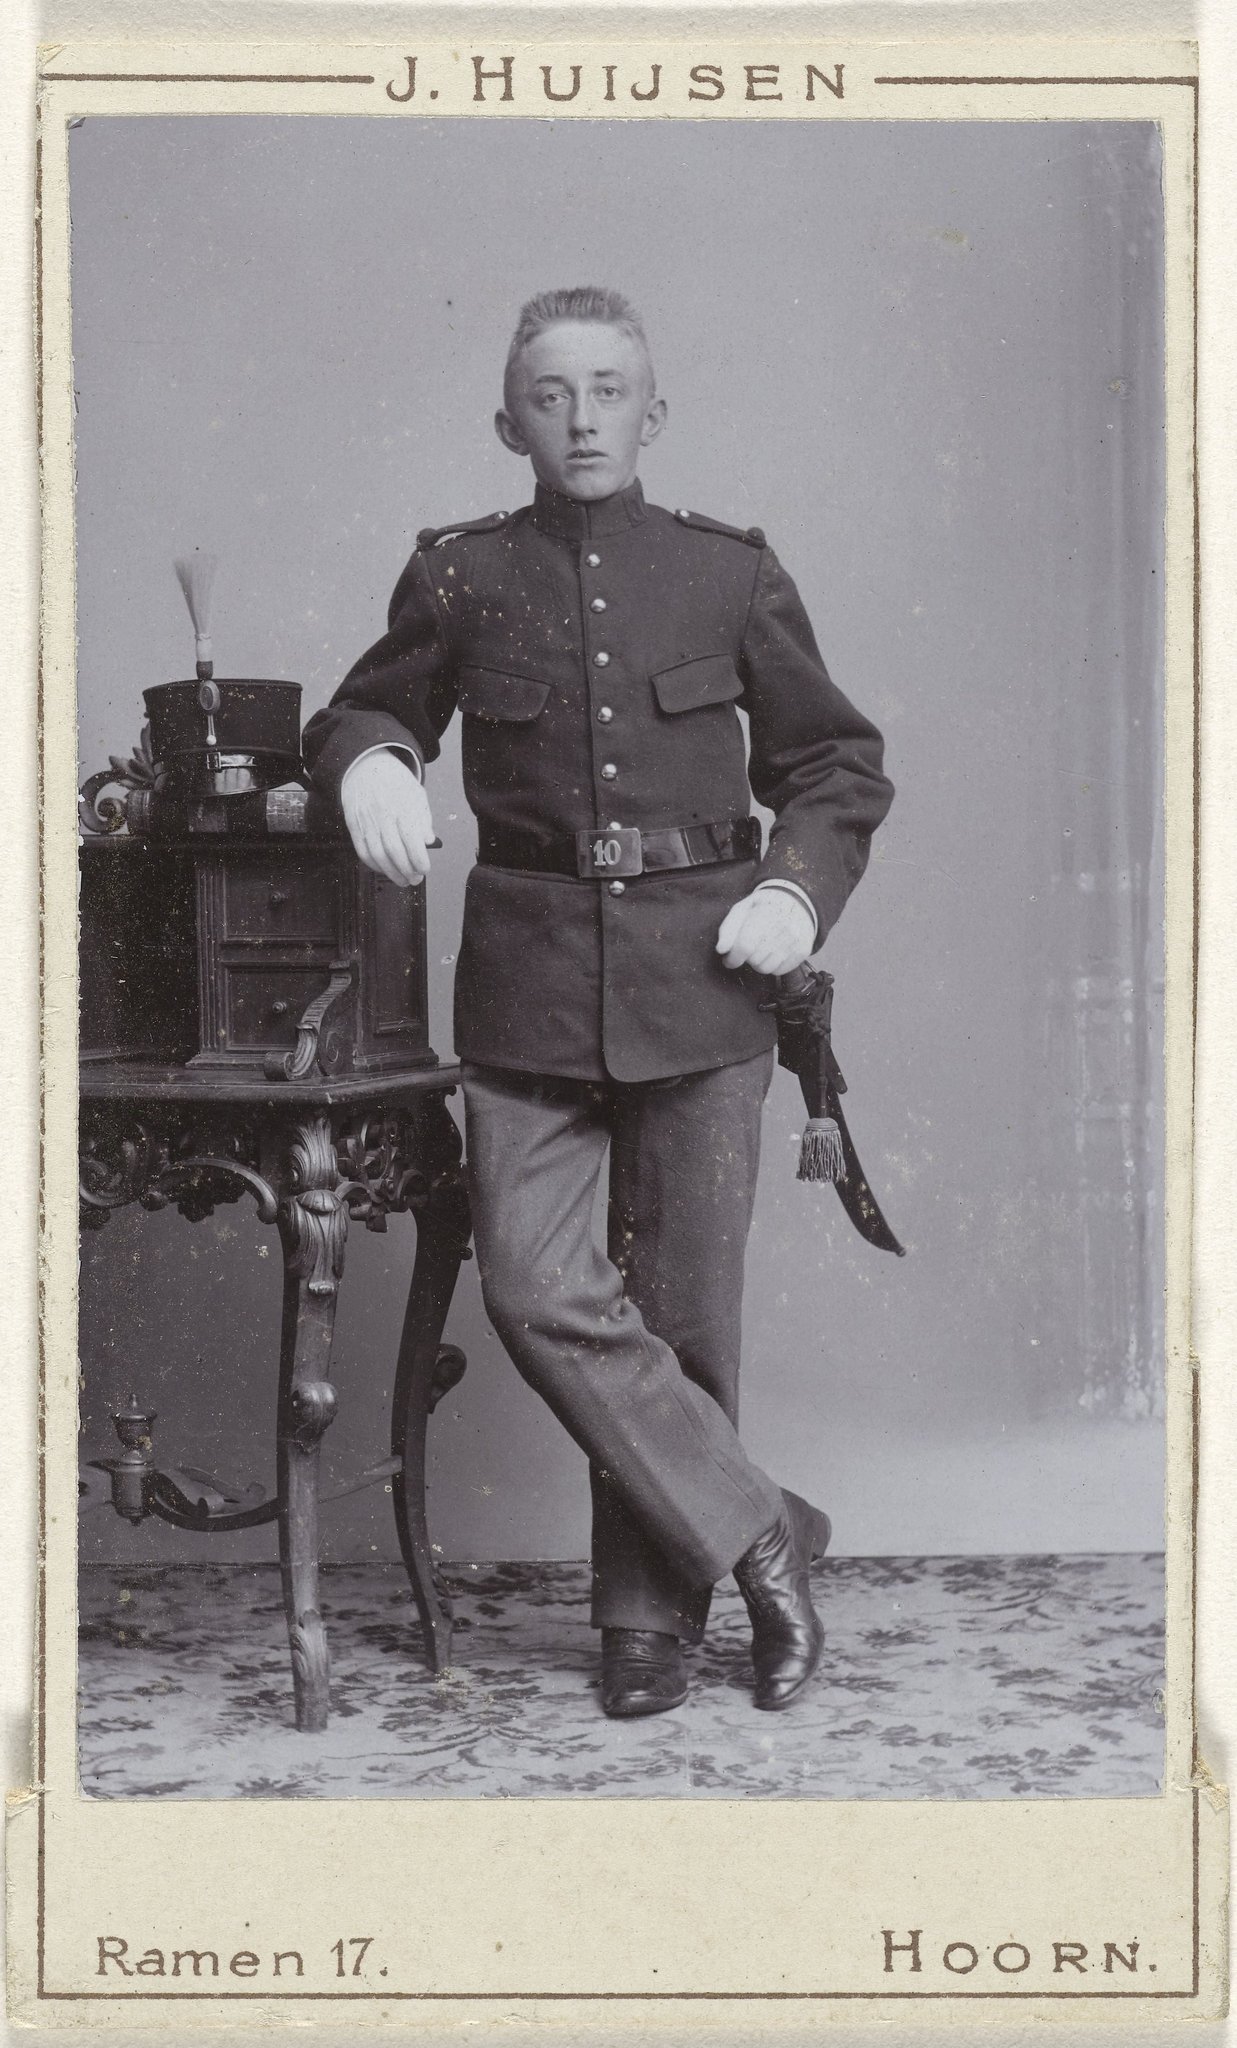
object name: photograph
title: Studioportret van man in uniform bij dressoir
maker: johannes laurens theodorus huijsen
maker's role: fotograaf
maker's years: 1852-1910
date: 1900-1920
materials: photographic support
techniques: albumen print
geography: hoorn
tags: hoorn (north holland)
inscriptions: name: ‘J.L.T. Huijsen photographe bekroond op vreschillende tentoonstellingen Hoorn, Ramen 17’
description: Studioportret van man in uniform bij dressoir